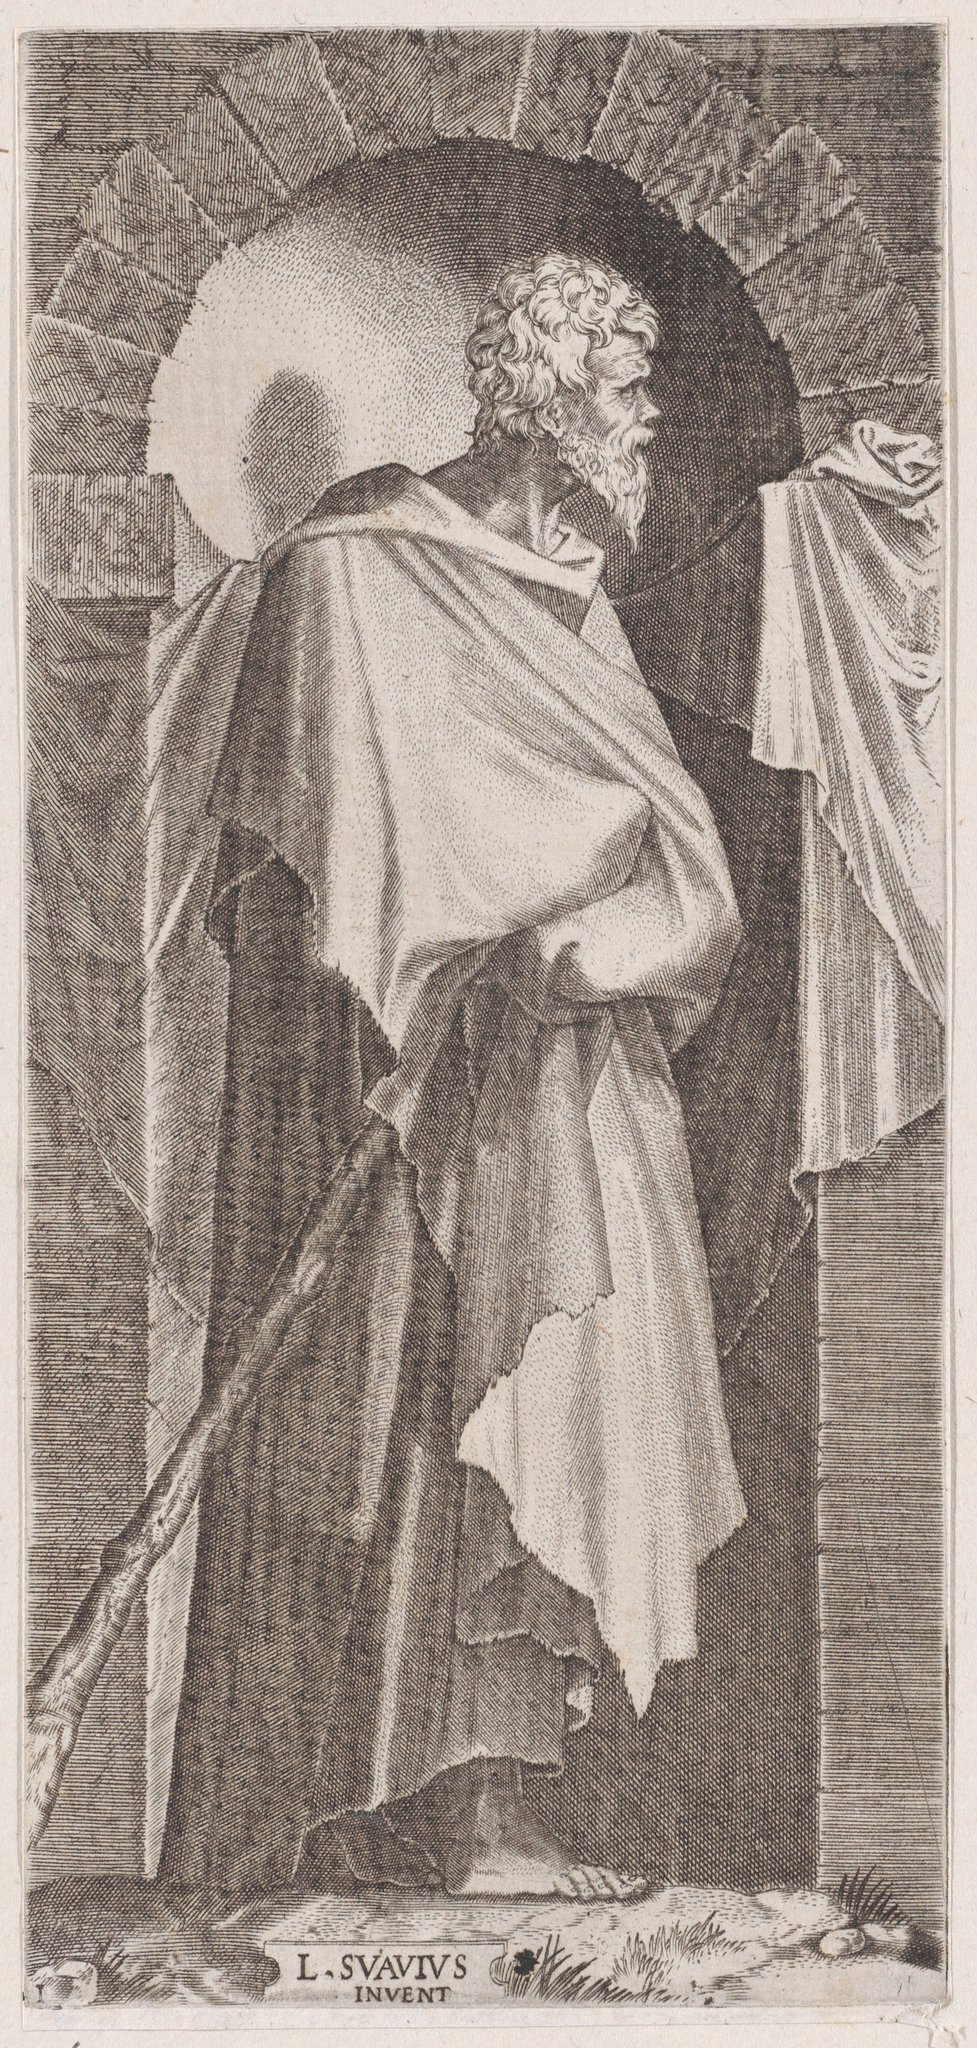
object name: print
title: St. James Minor, from "Christ, the Twelve Apostles and St. Paul"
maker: lambert suavius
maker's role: artist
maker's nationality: netherlandish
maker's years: 1510-1576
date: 1525-1576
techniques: engraving